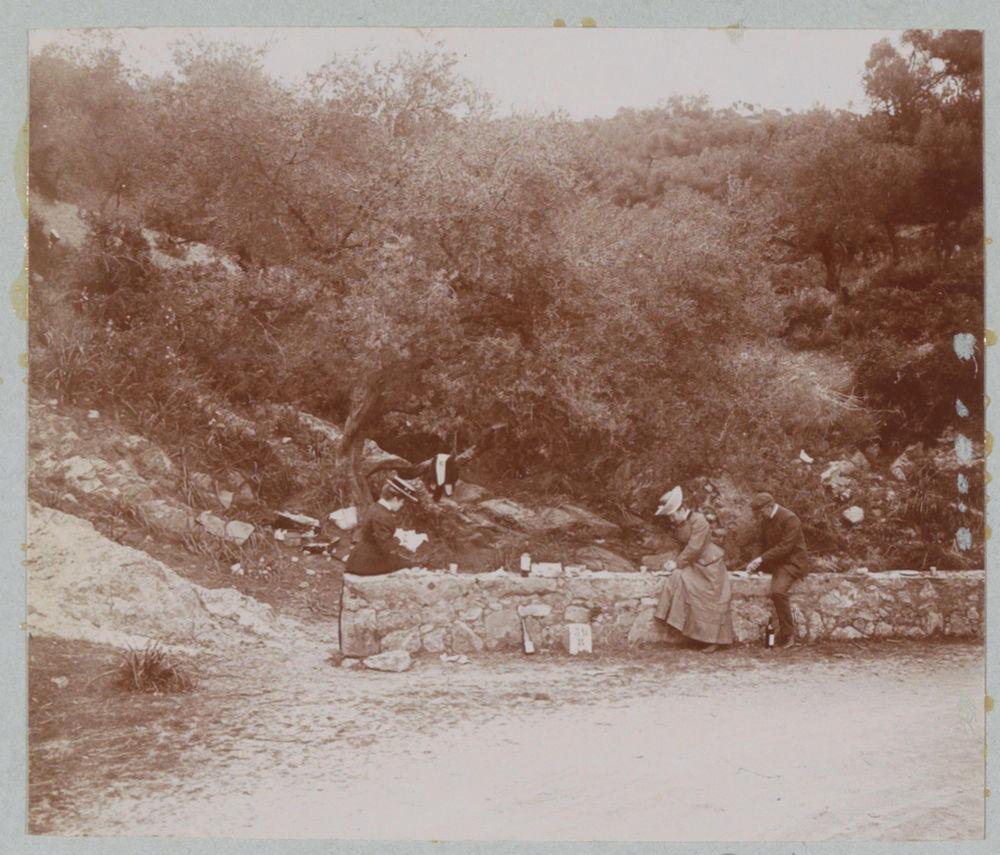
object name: photograph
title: Twee vrouwen en een man picknickend langs de kant van de weg, vermoedelijk op Corsica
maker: Anonymous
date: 1905-1910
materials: paper, photographic support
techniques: gelatin silver print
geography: corsica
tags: eating and drinking, public road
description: Onderdeel van Fotoalbum van een Franse amateurfotograaf met bezienswaardigheden in Frankrijk, Zwitserland en Italië.